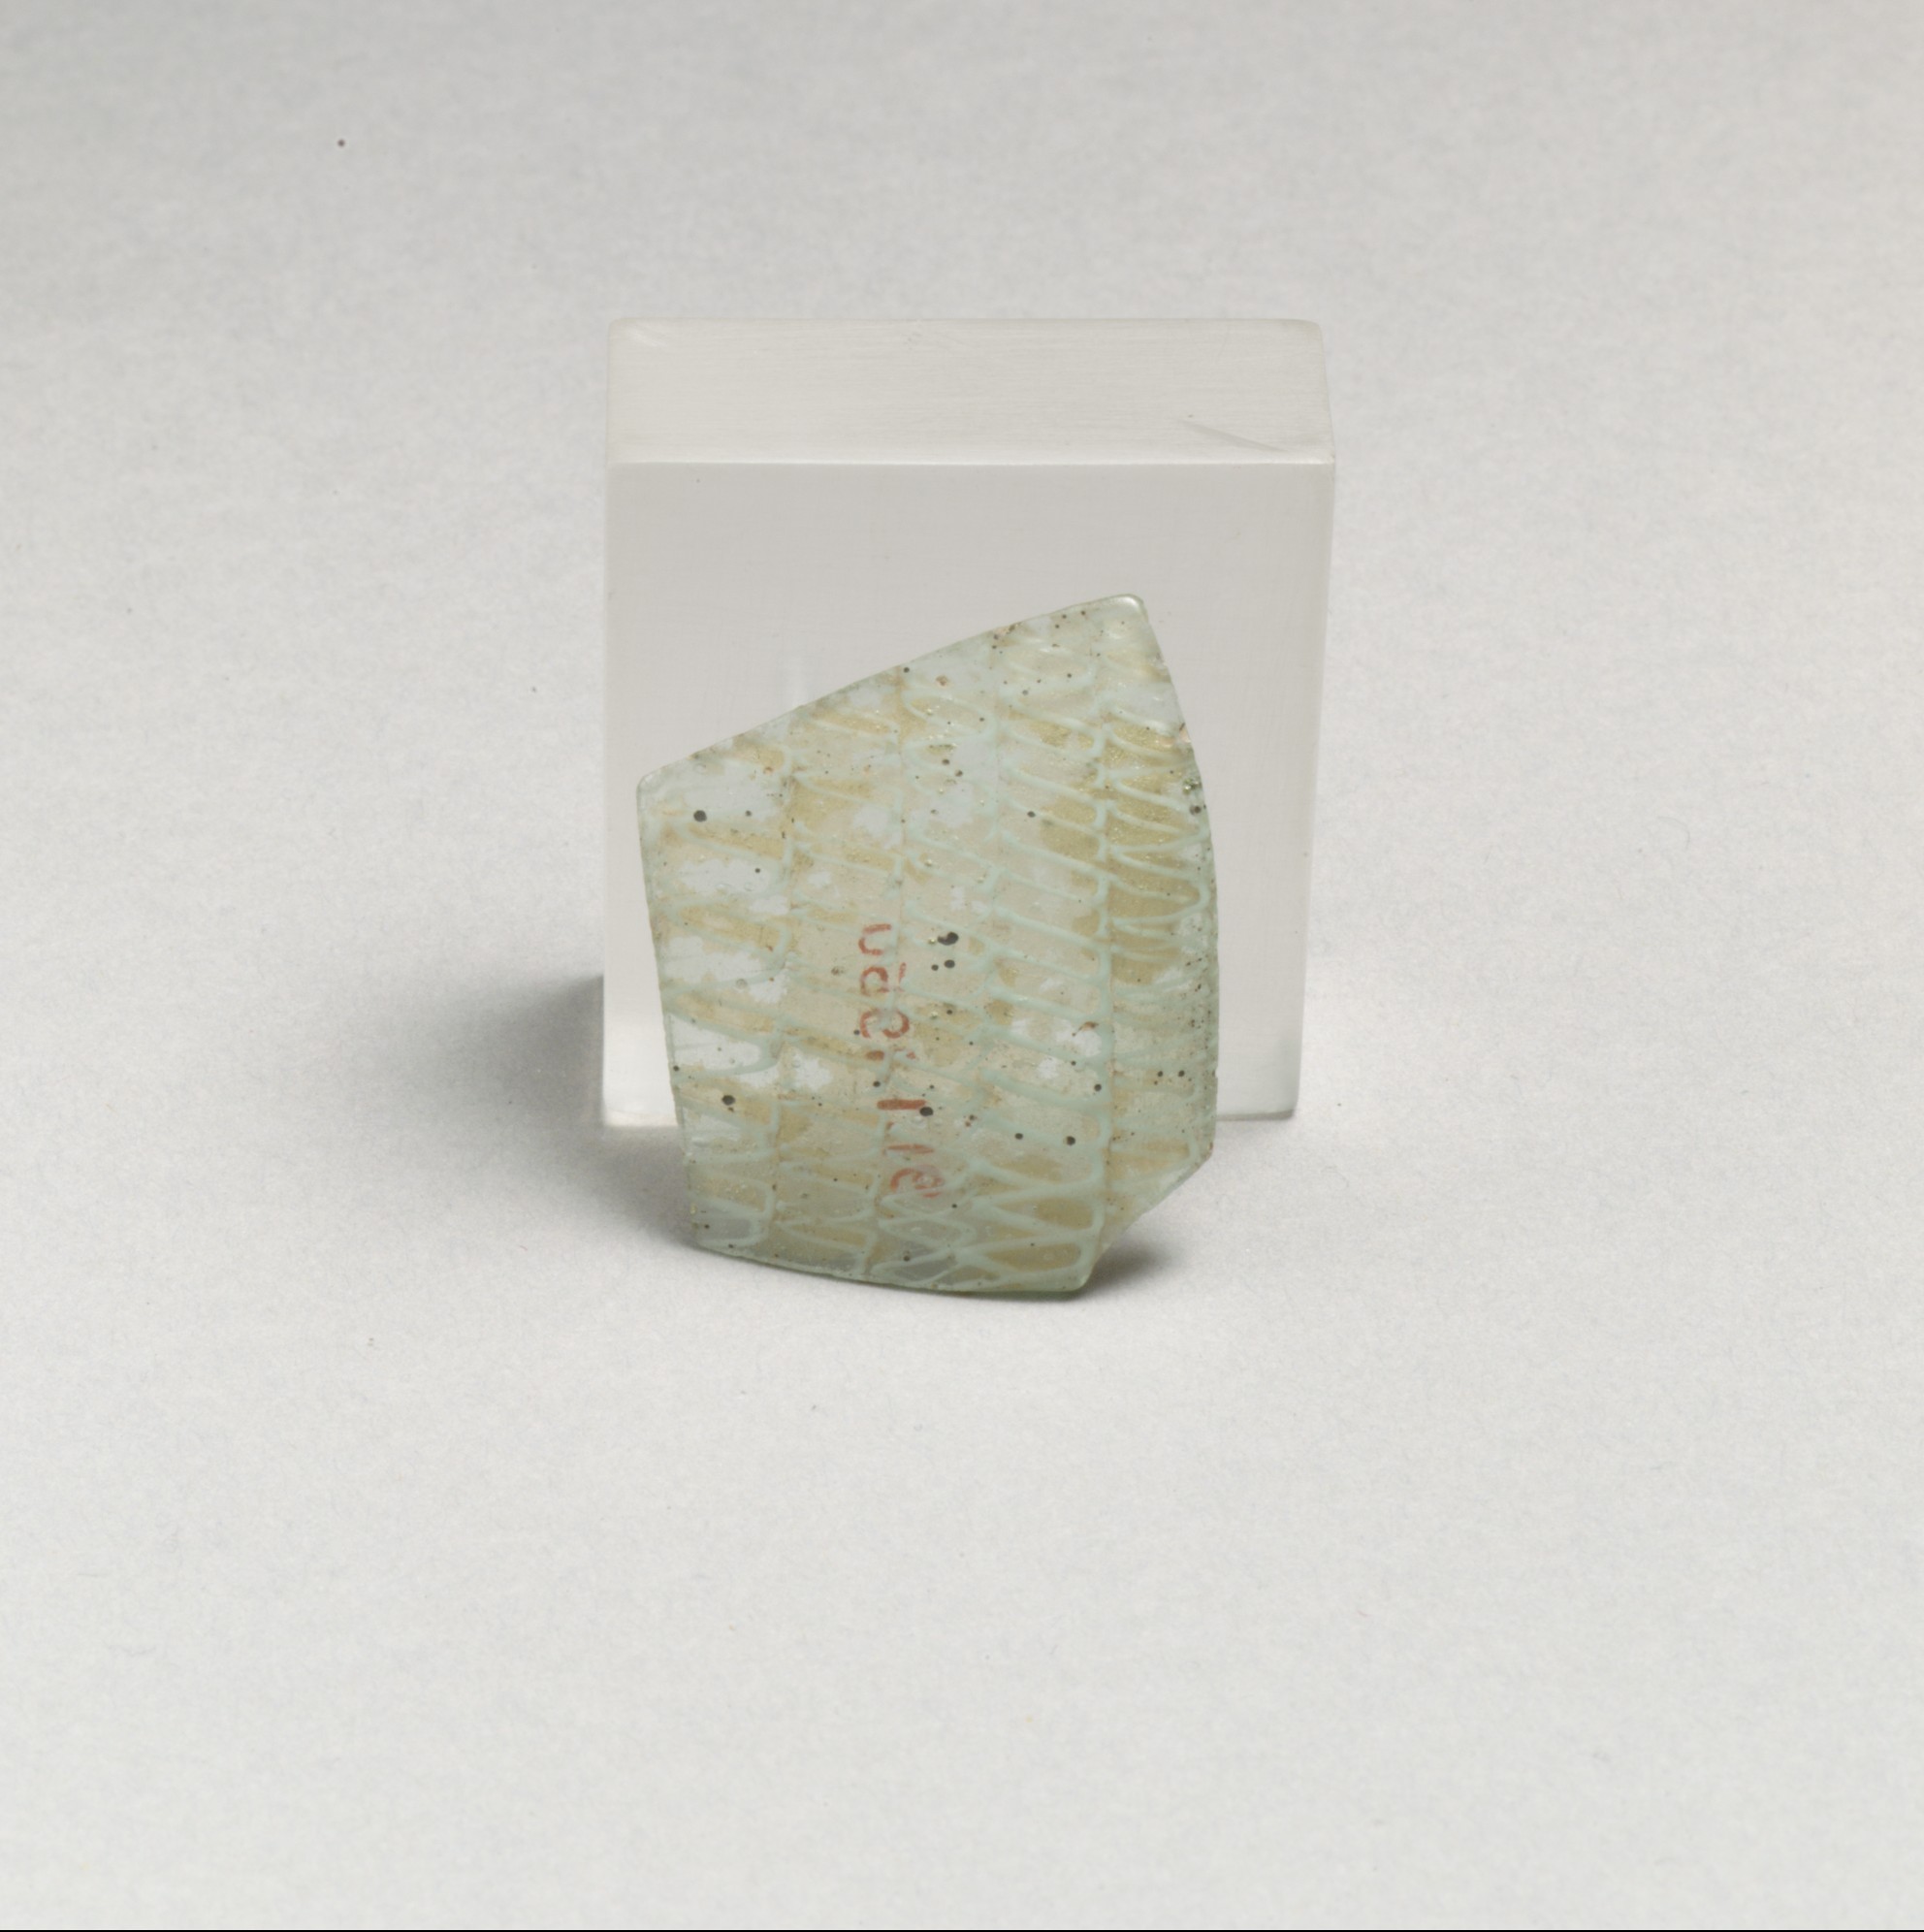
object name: fragment, network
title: Glass network mosaic fragment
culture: roman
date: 34 BCE-33 CE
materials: glass